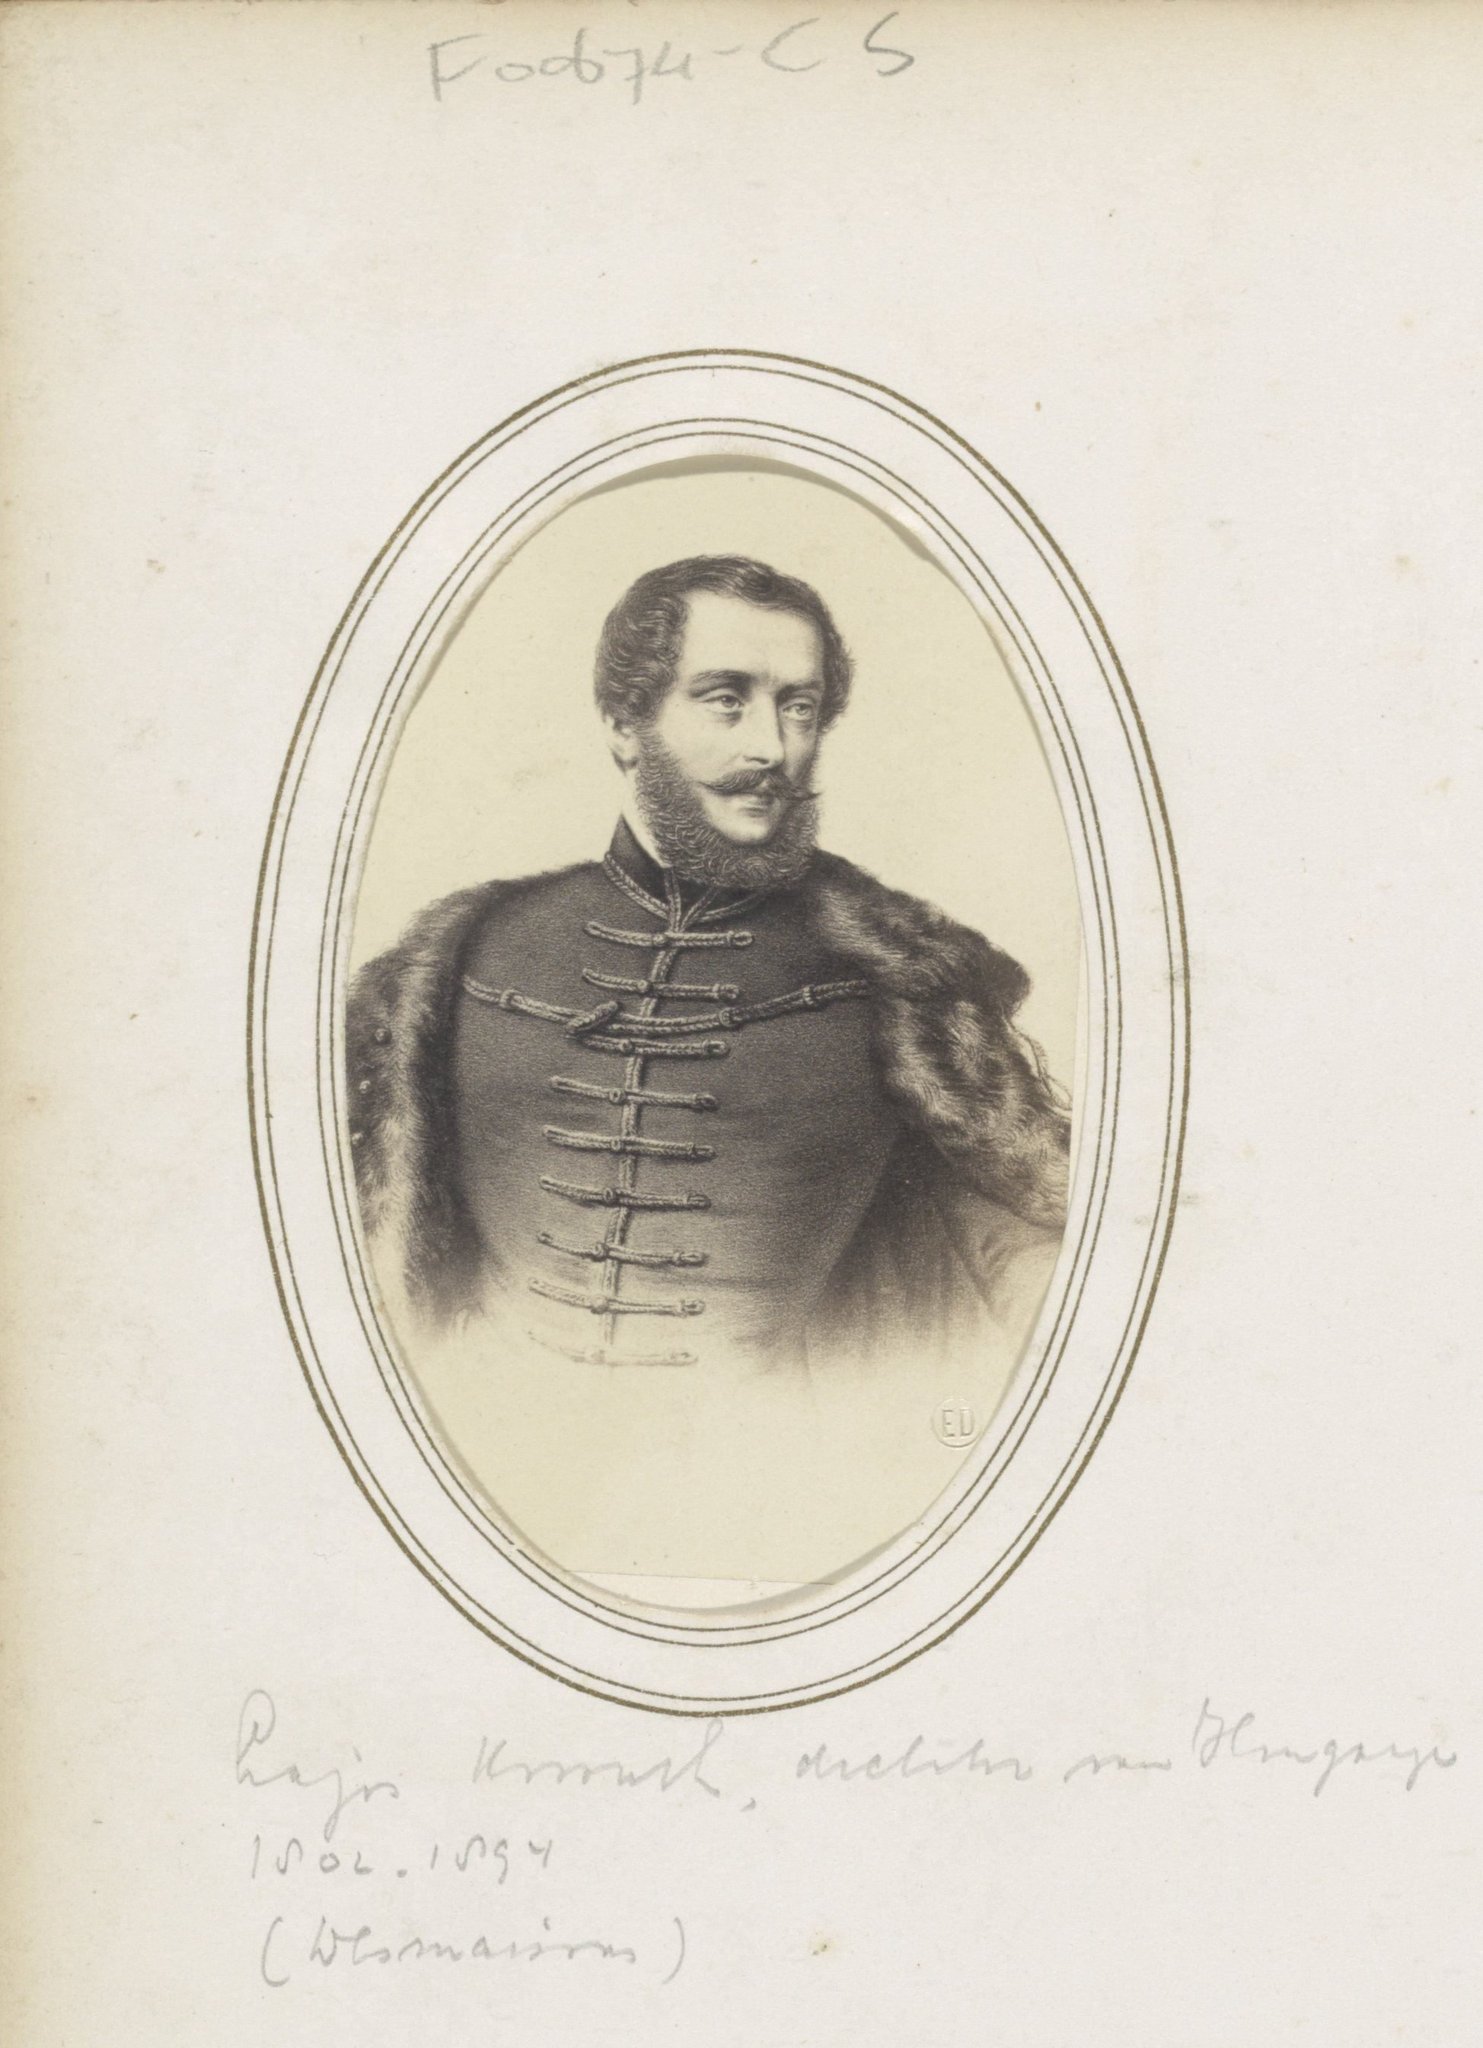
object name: carte de visite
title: Fotoreproductie van een getekend portret van Lajos Kossuth, Hongaars politicus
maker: émilien desmaisons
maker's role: draughtsman, print maker, publisher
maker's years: 1812-1880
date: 1855-1870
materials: cardboard, paper, photographic support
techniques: albumen print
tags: minister ~ government, coat (+ fur used for clothes), historical persons, politician, e.g. party leader, (military) uniforms, beard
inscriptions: address: ‘22, Rue de l'Arbre-Sec Près le pont Neuf Paris Ci-devant Rue des Grands Augustine, 5’, inscription: ‘Cossut’, check stamp: ‘ED’, inscription: ‘Lajos Kossuth 1802-1894’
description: Onderdeel van Fotoalbum met 123 cartes-de-visite van leden van Europese vorstenhuizen, politici en bekende personen.